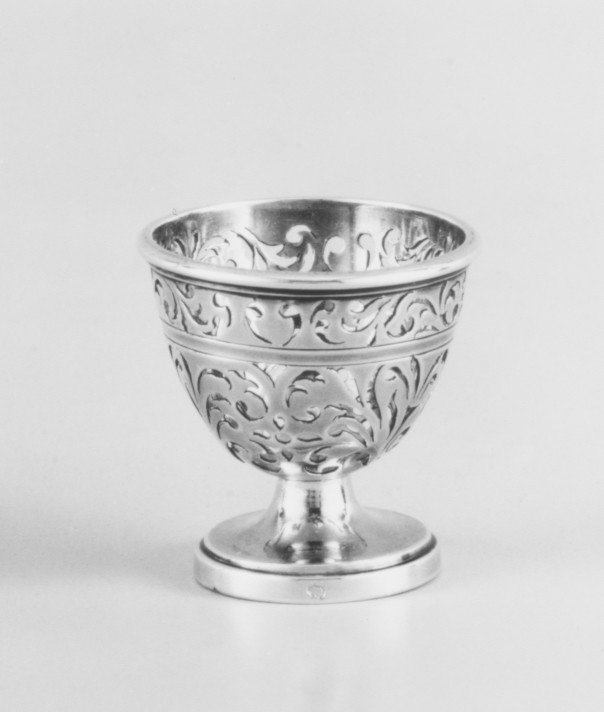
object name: egg cup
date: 1786-1787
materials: silver